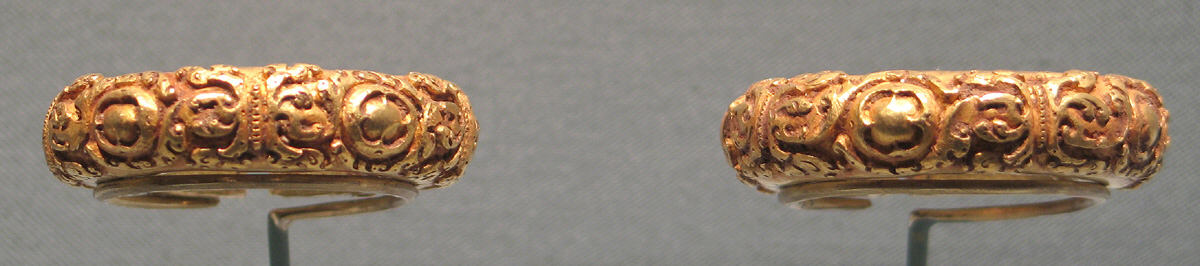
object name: bracelet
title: Pair of Bracelets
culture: indonesian, javanese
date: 701-933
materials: gold